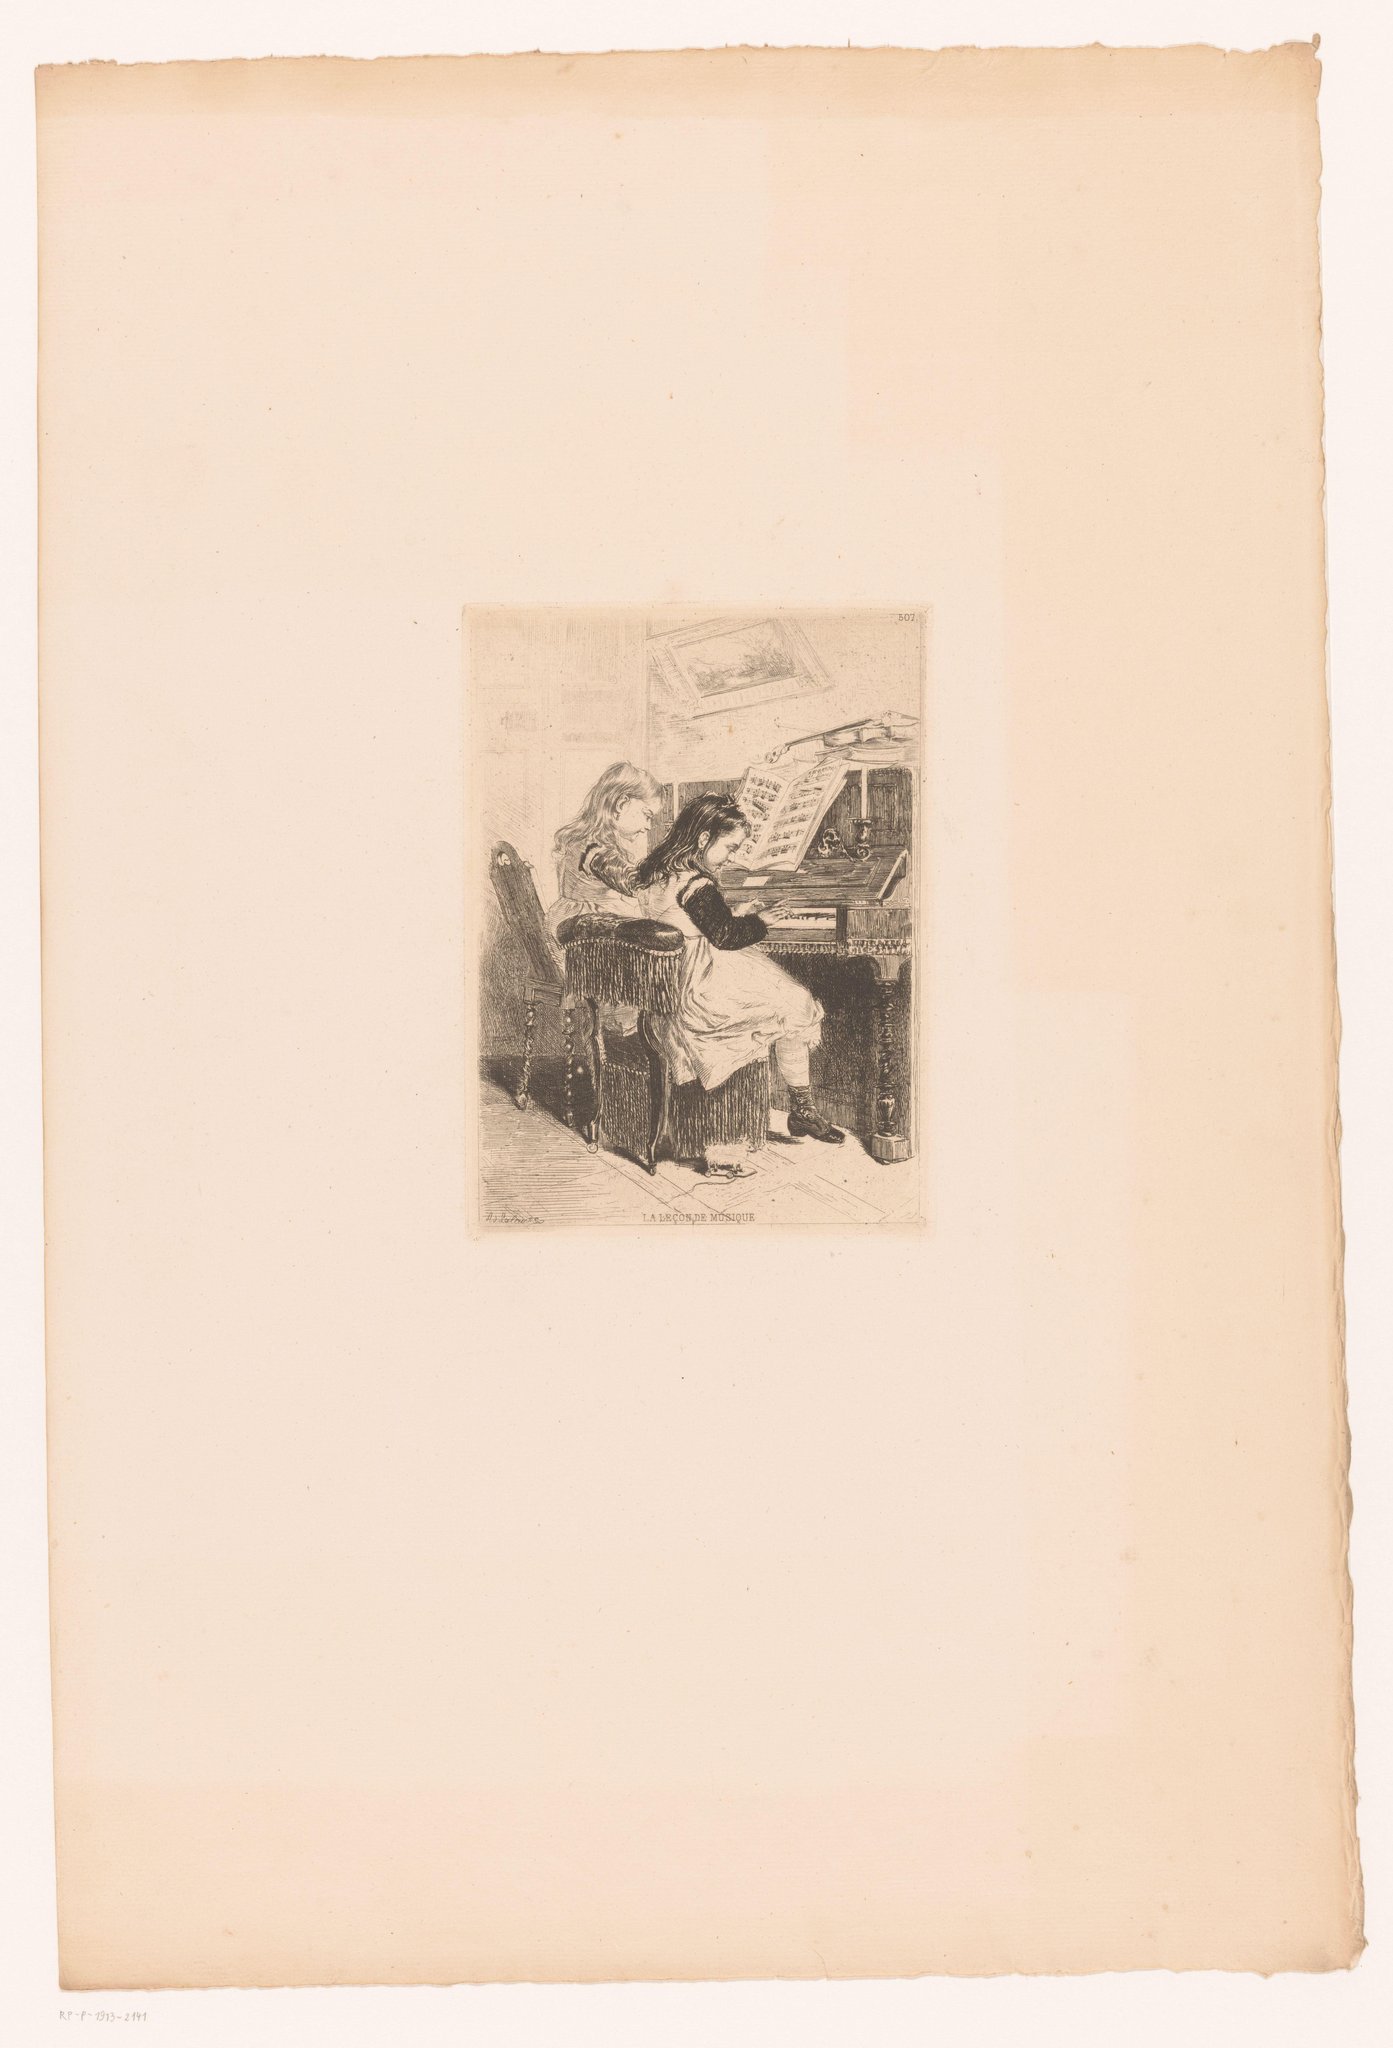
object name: print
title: Pianospelende meisjes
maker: adolphe lalauze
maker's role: print maker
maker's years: 1838-1906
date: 1880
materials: paper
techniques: drypoint, engraving, etching, intaglio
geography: france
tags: child (at home) - aa - girl, pianoforte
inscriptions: collector's mark: Lugt 2233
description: Gepubliceerd in: L'Illustration nouvelle, 1880.